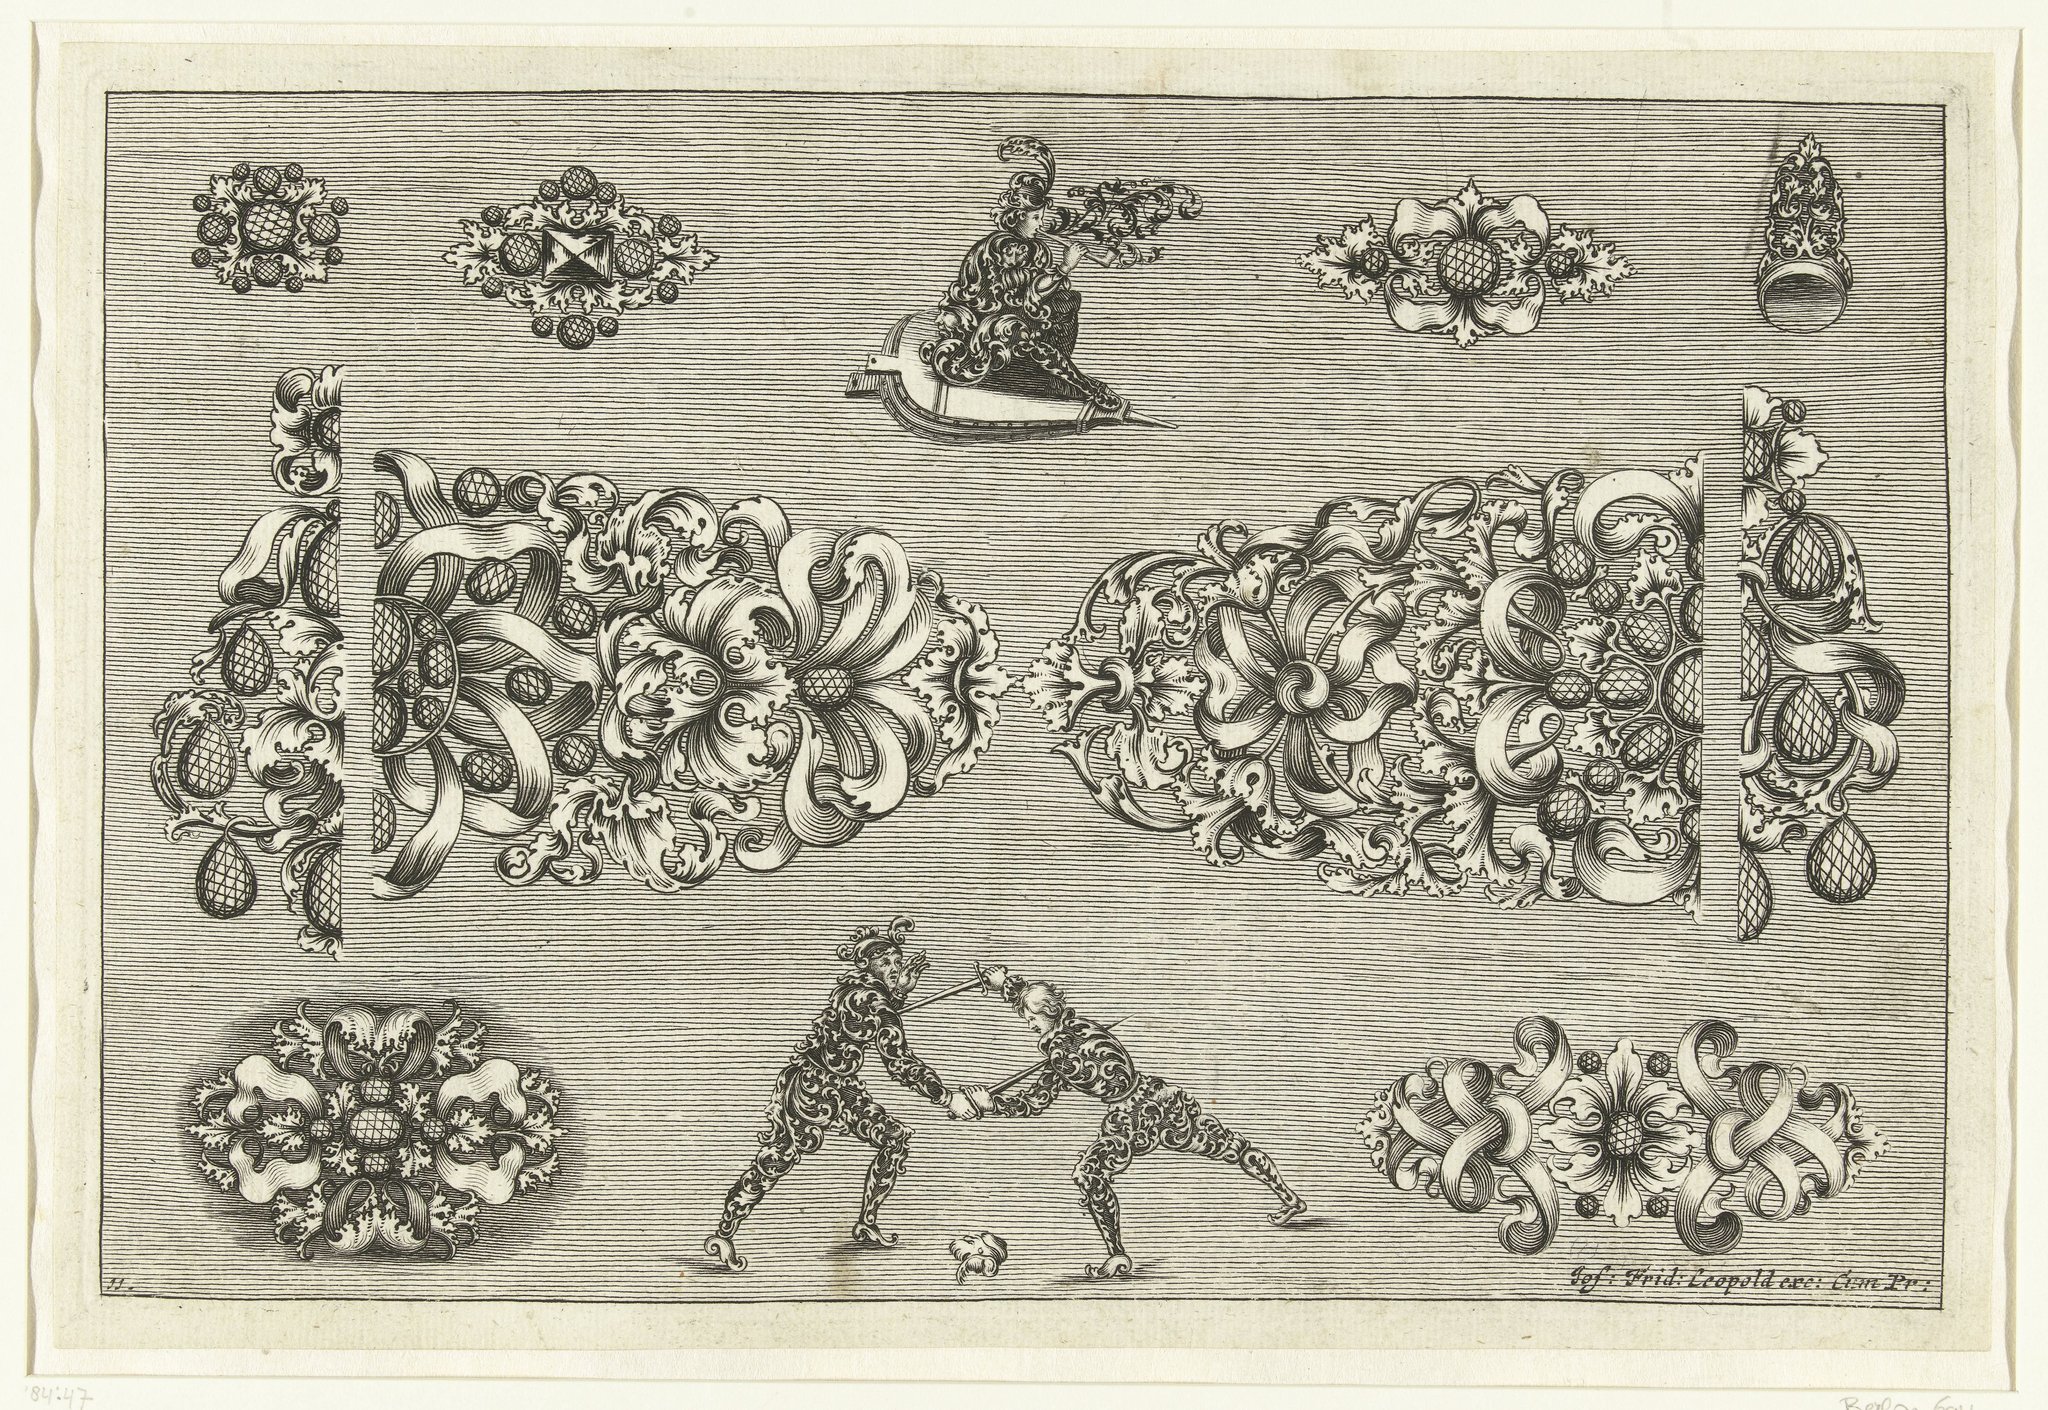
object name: print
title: Tien ontwerpen voor juwelen en drie figuren van bladranken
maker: joseph friedrich leopold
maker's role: print maker, publisher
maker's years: 1668-1726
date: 1695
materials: paper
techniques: engraving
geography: germany